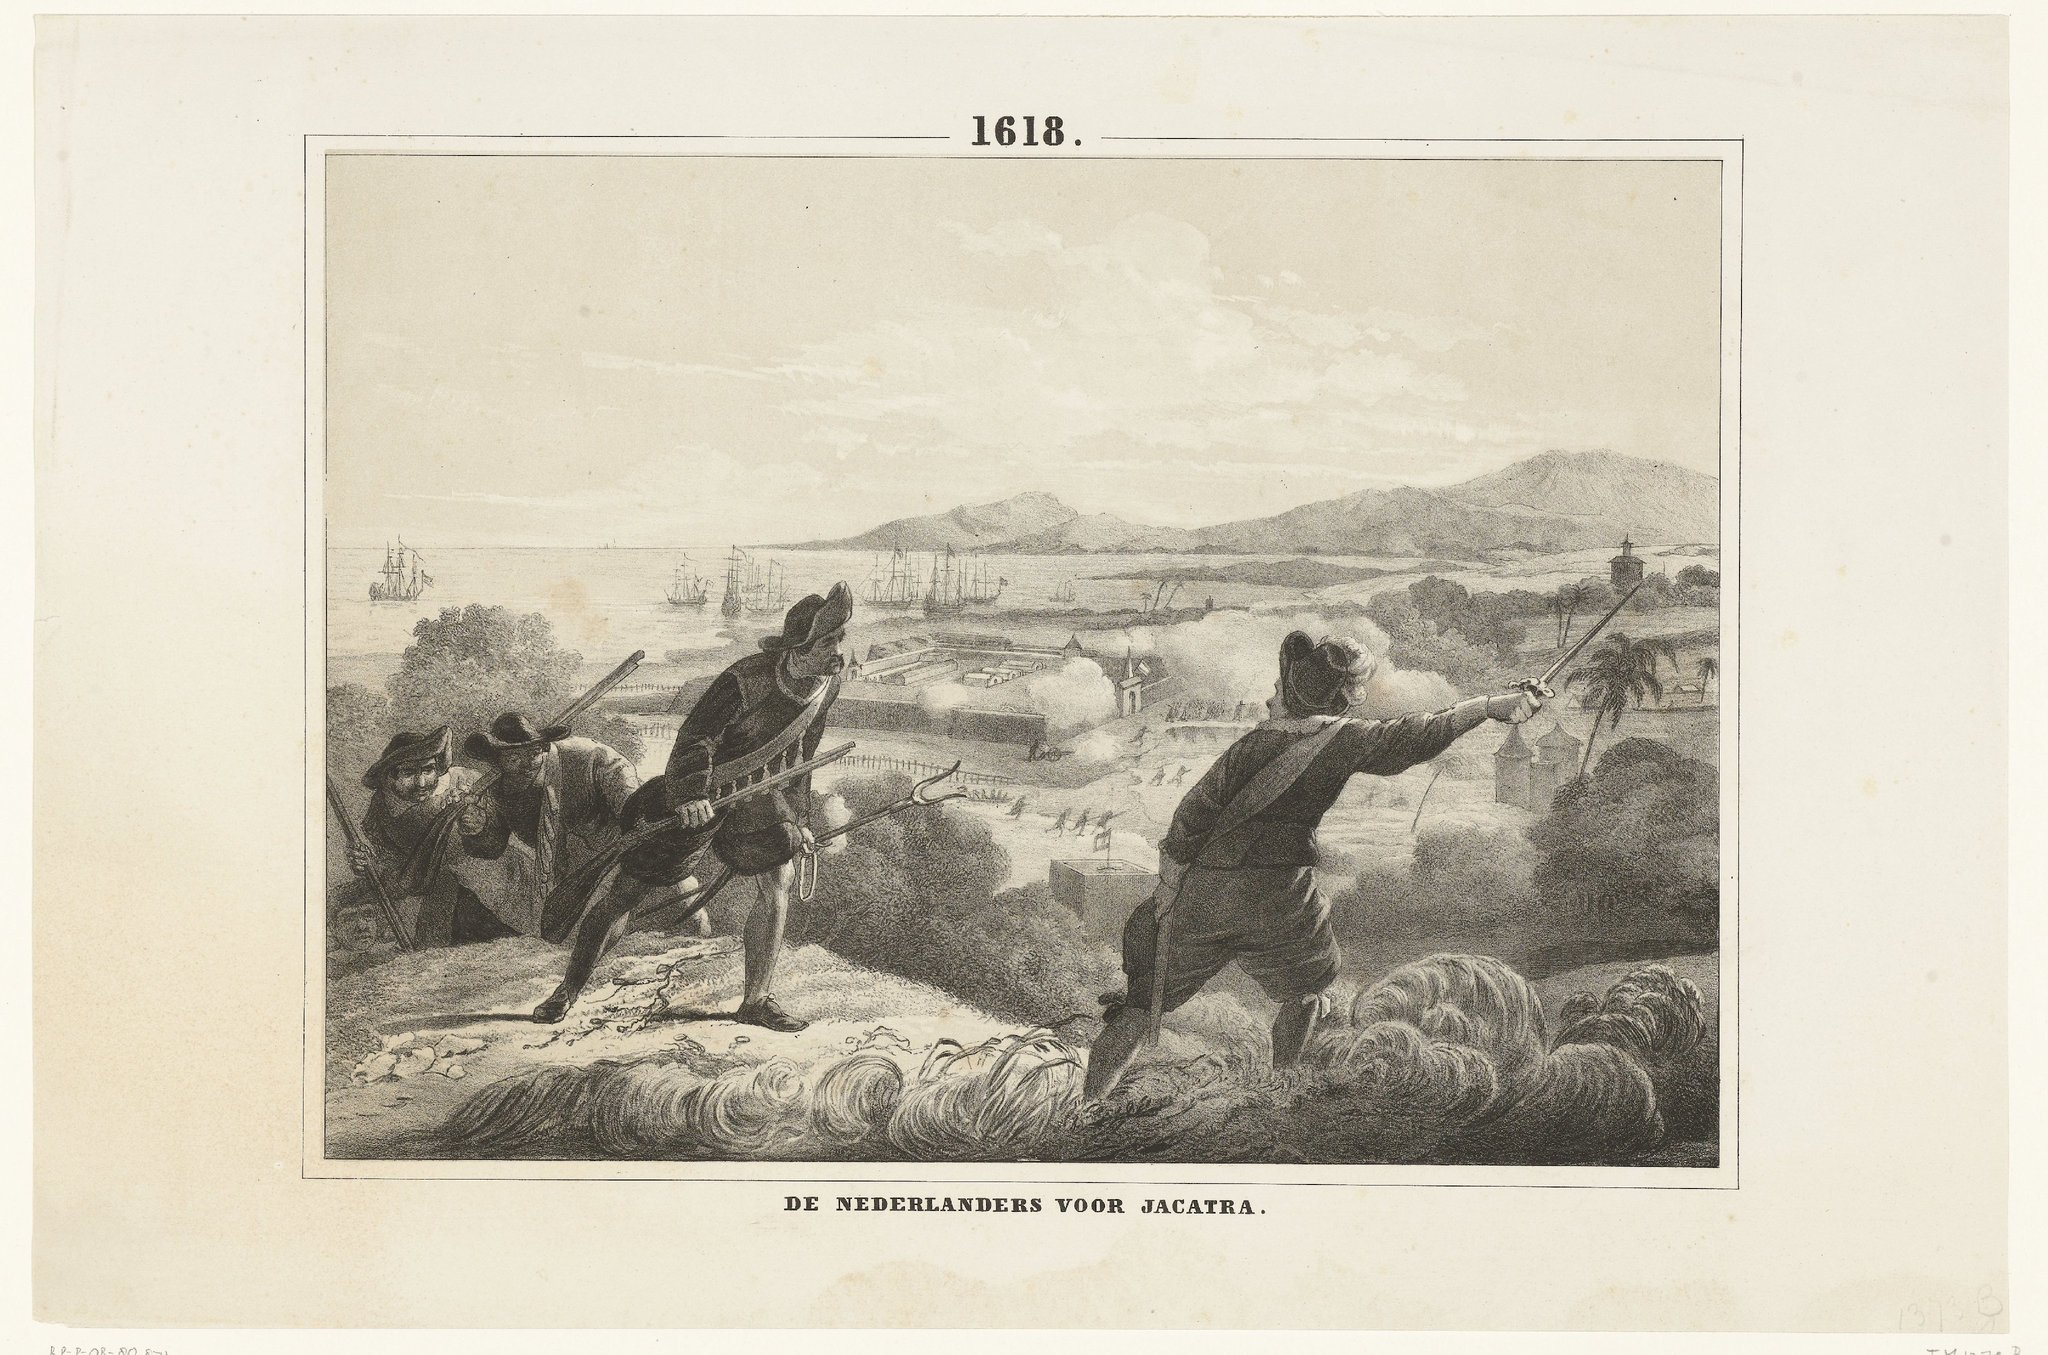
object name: print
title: Vechtende Hollandse soldaten bij het kasteel van Batavia, 1618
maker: Anonymous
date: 1853-1855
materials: paper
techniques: tone lithography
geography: netherlands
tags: battle, fighting in general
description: Illustratie voor: J.H. Eichman & H. Altmann, Vaderlandsche historieplaten voor scholen en huisgezinnen, Leiden, 1855. Dit nummer is een door het RPK toegevoegd nummer en staat niet in Frederik Muller, het werk waar de prent voor is gemaakt of uit afkomstig is, staat wel vermeld in Frederik Muller.